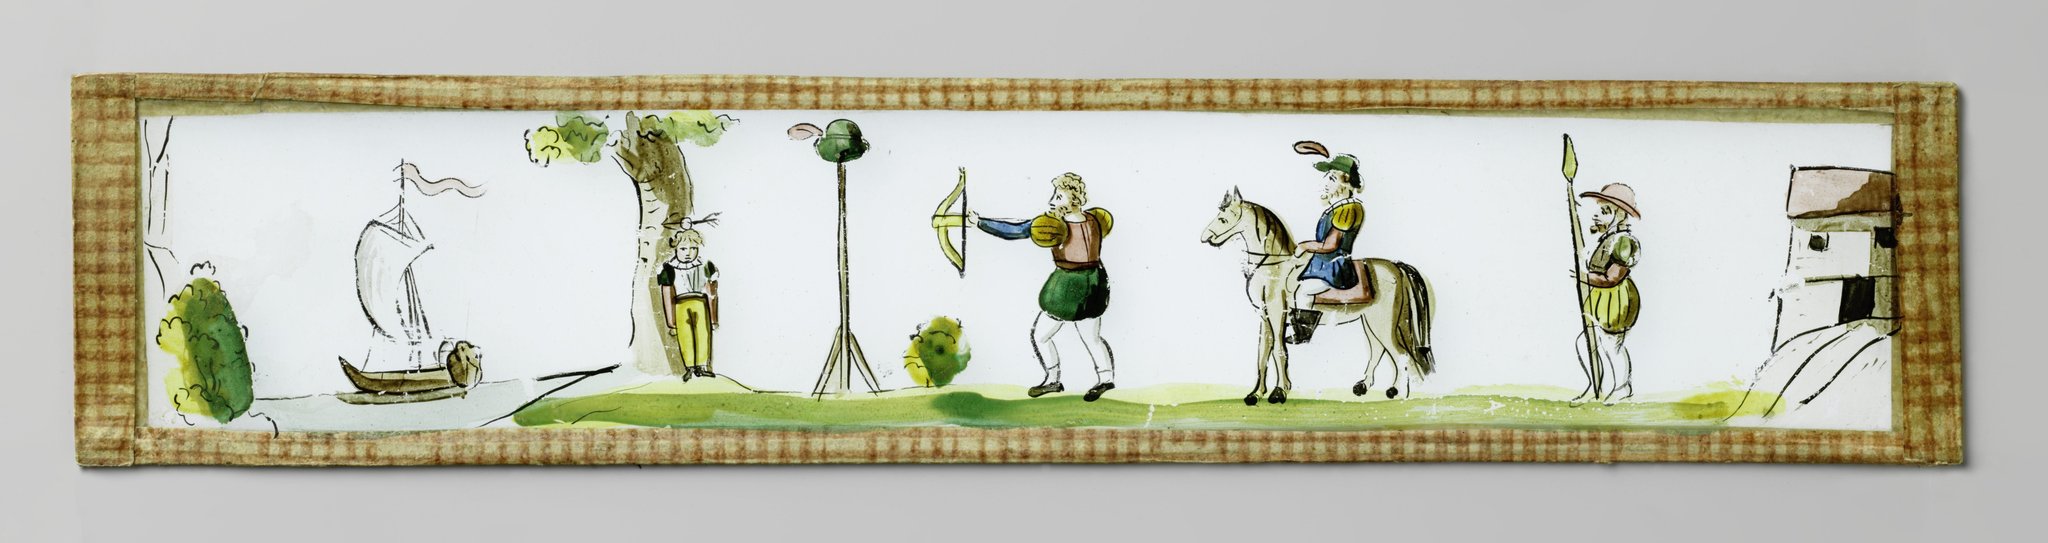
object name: lantern slide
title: Toverlantaarnplaatjes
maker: Anonymous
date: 1800-1900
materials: glass, paint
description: Een toverlantaarnplaat waarop staat afgebeeld een soldaat met een speer, een ruiter, een boogschutter die een appel van het hoofd van een staande man schiet en een zeilboot.